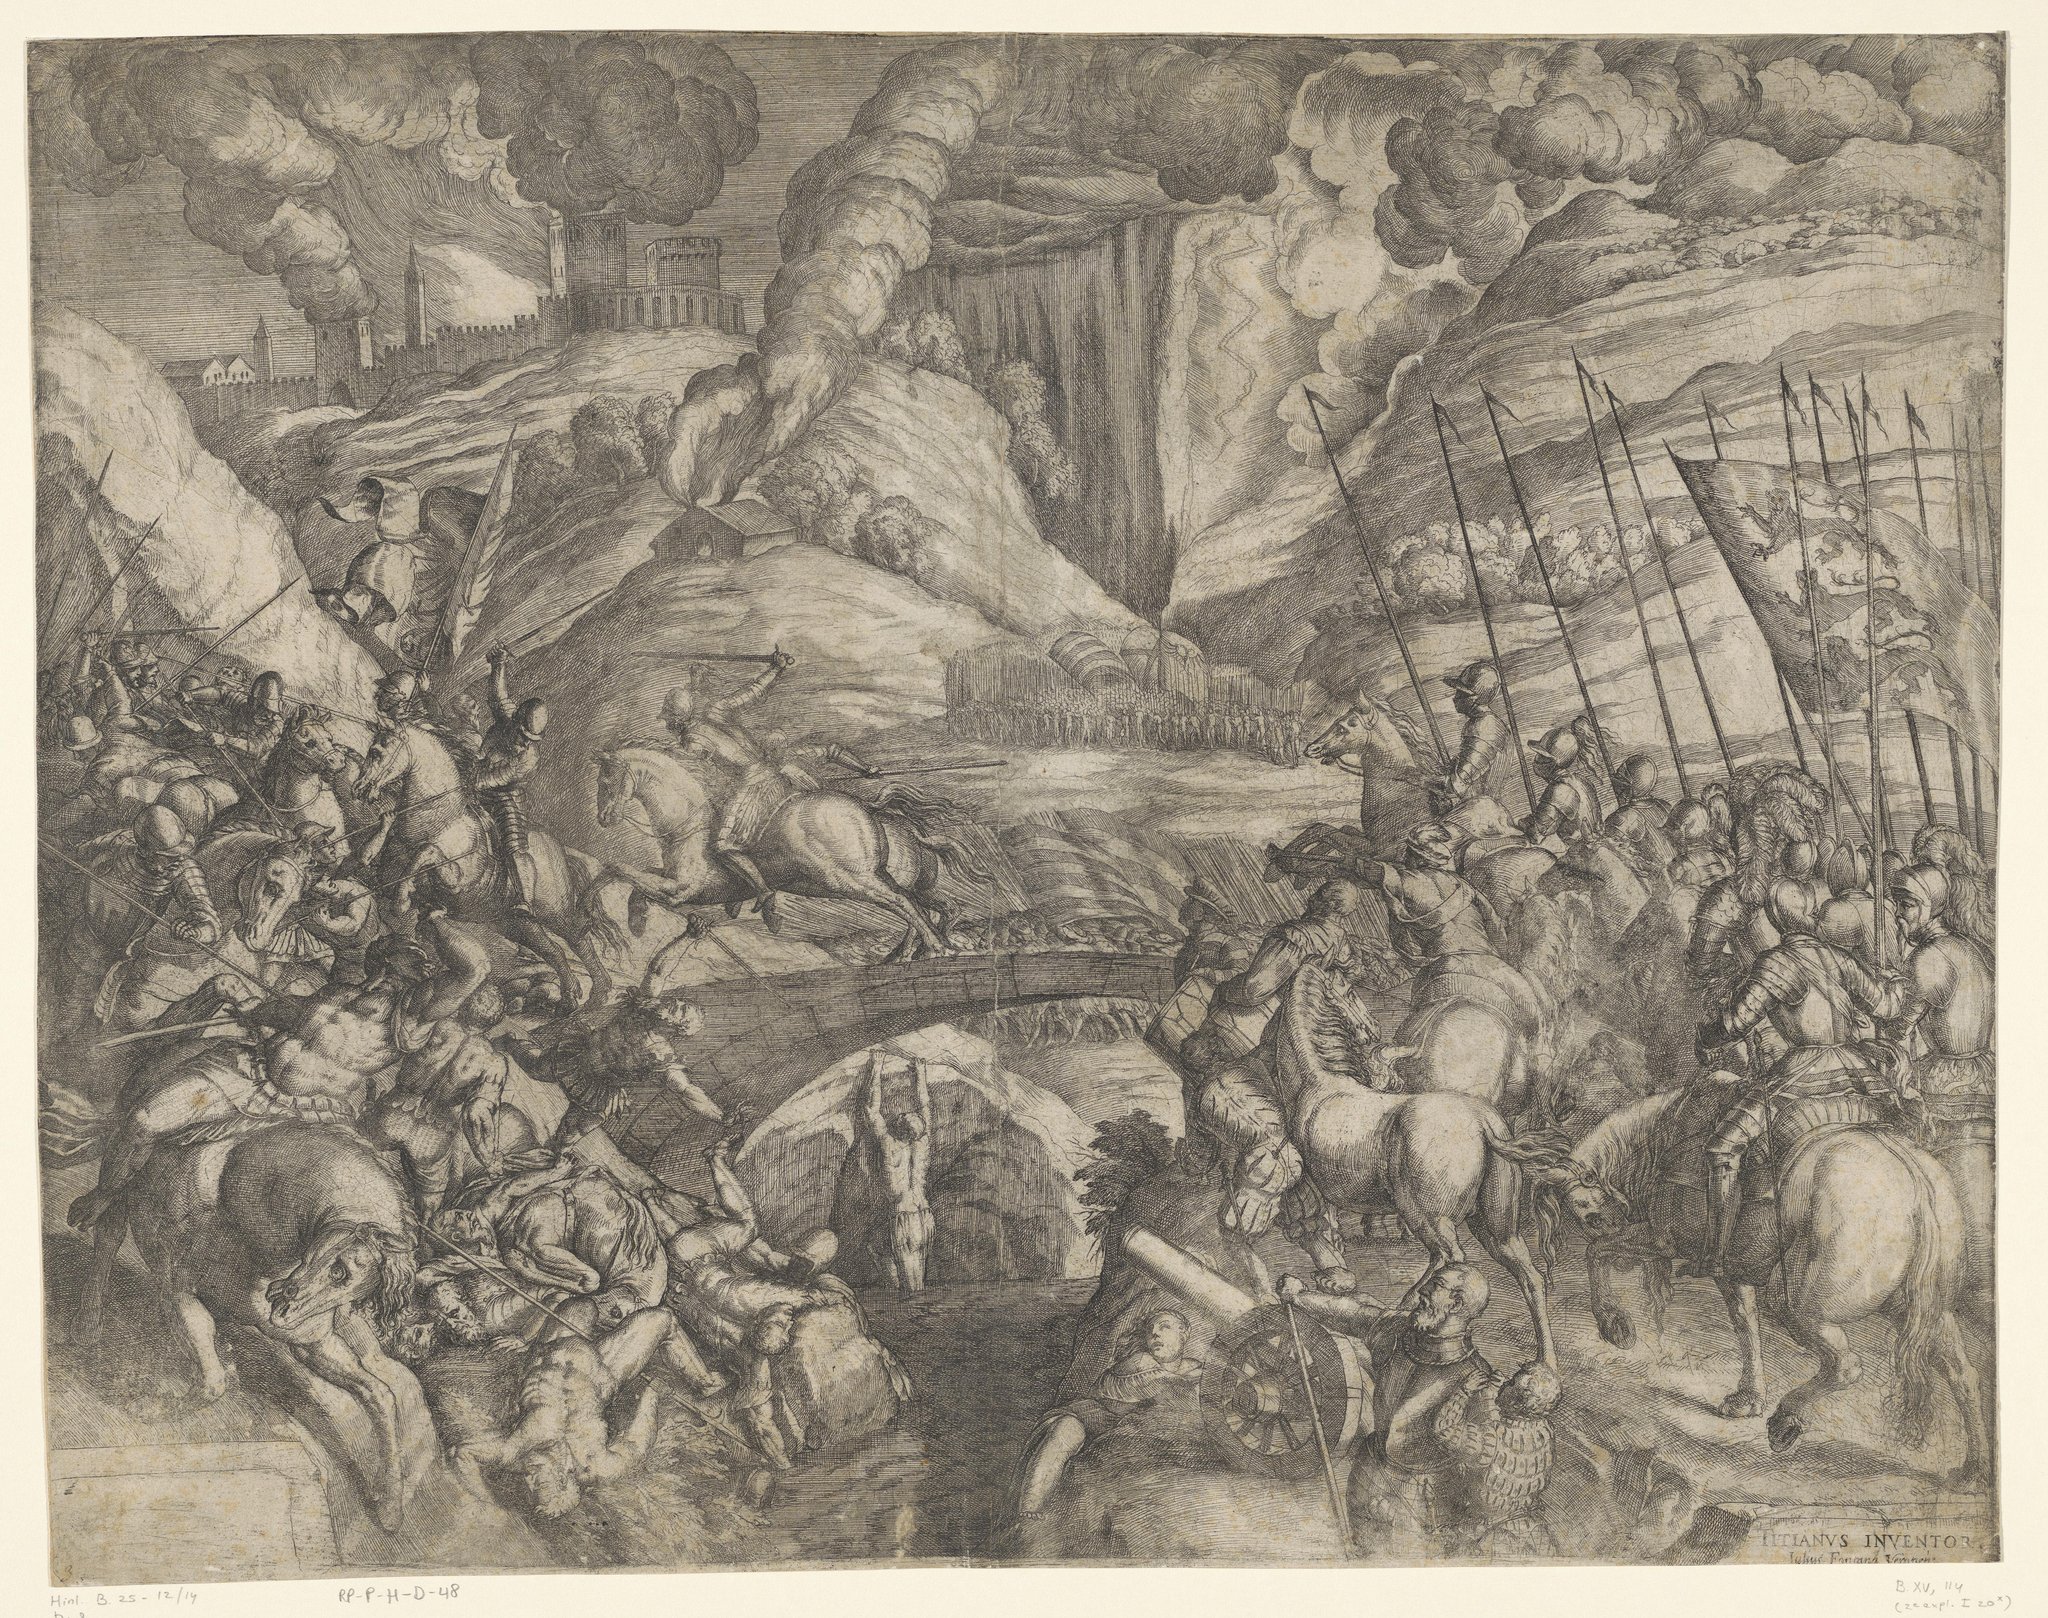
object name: print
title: Slag bij Cadore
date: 1553-1582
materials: paper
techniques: etching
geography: venice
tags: battle, warfare; military affairs (+ cavalry, horsemen), the soldier; the soldier's life, fighting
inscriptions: collector's mark: Lugt 11, collector's mark: ‘Hinloopen’, collector's mark: Lugt 10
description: Gevecht tussen twee legers bij een brug in Cadore. Het Venetiaanse leger duwt de vijand in het water. Op de achtergrond een brandende stad op een heuvel.